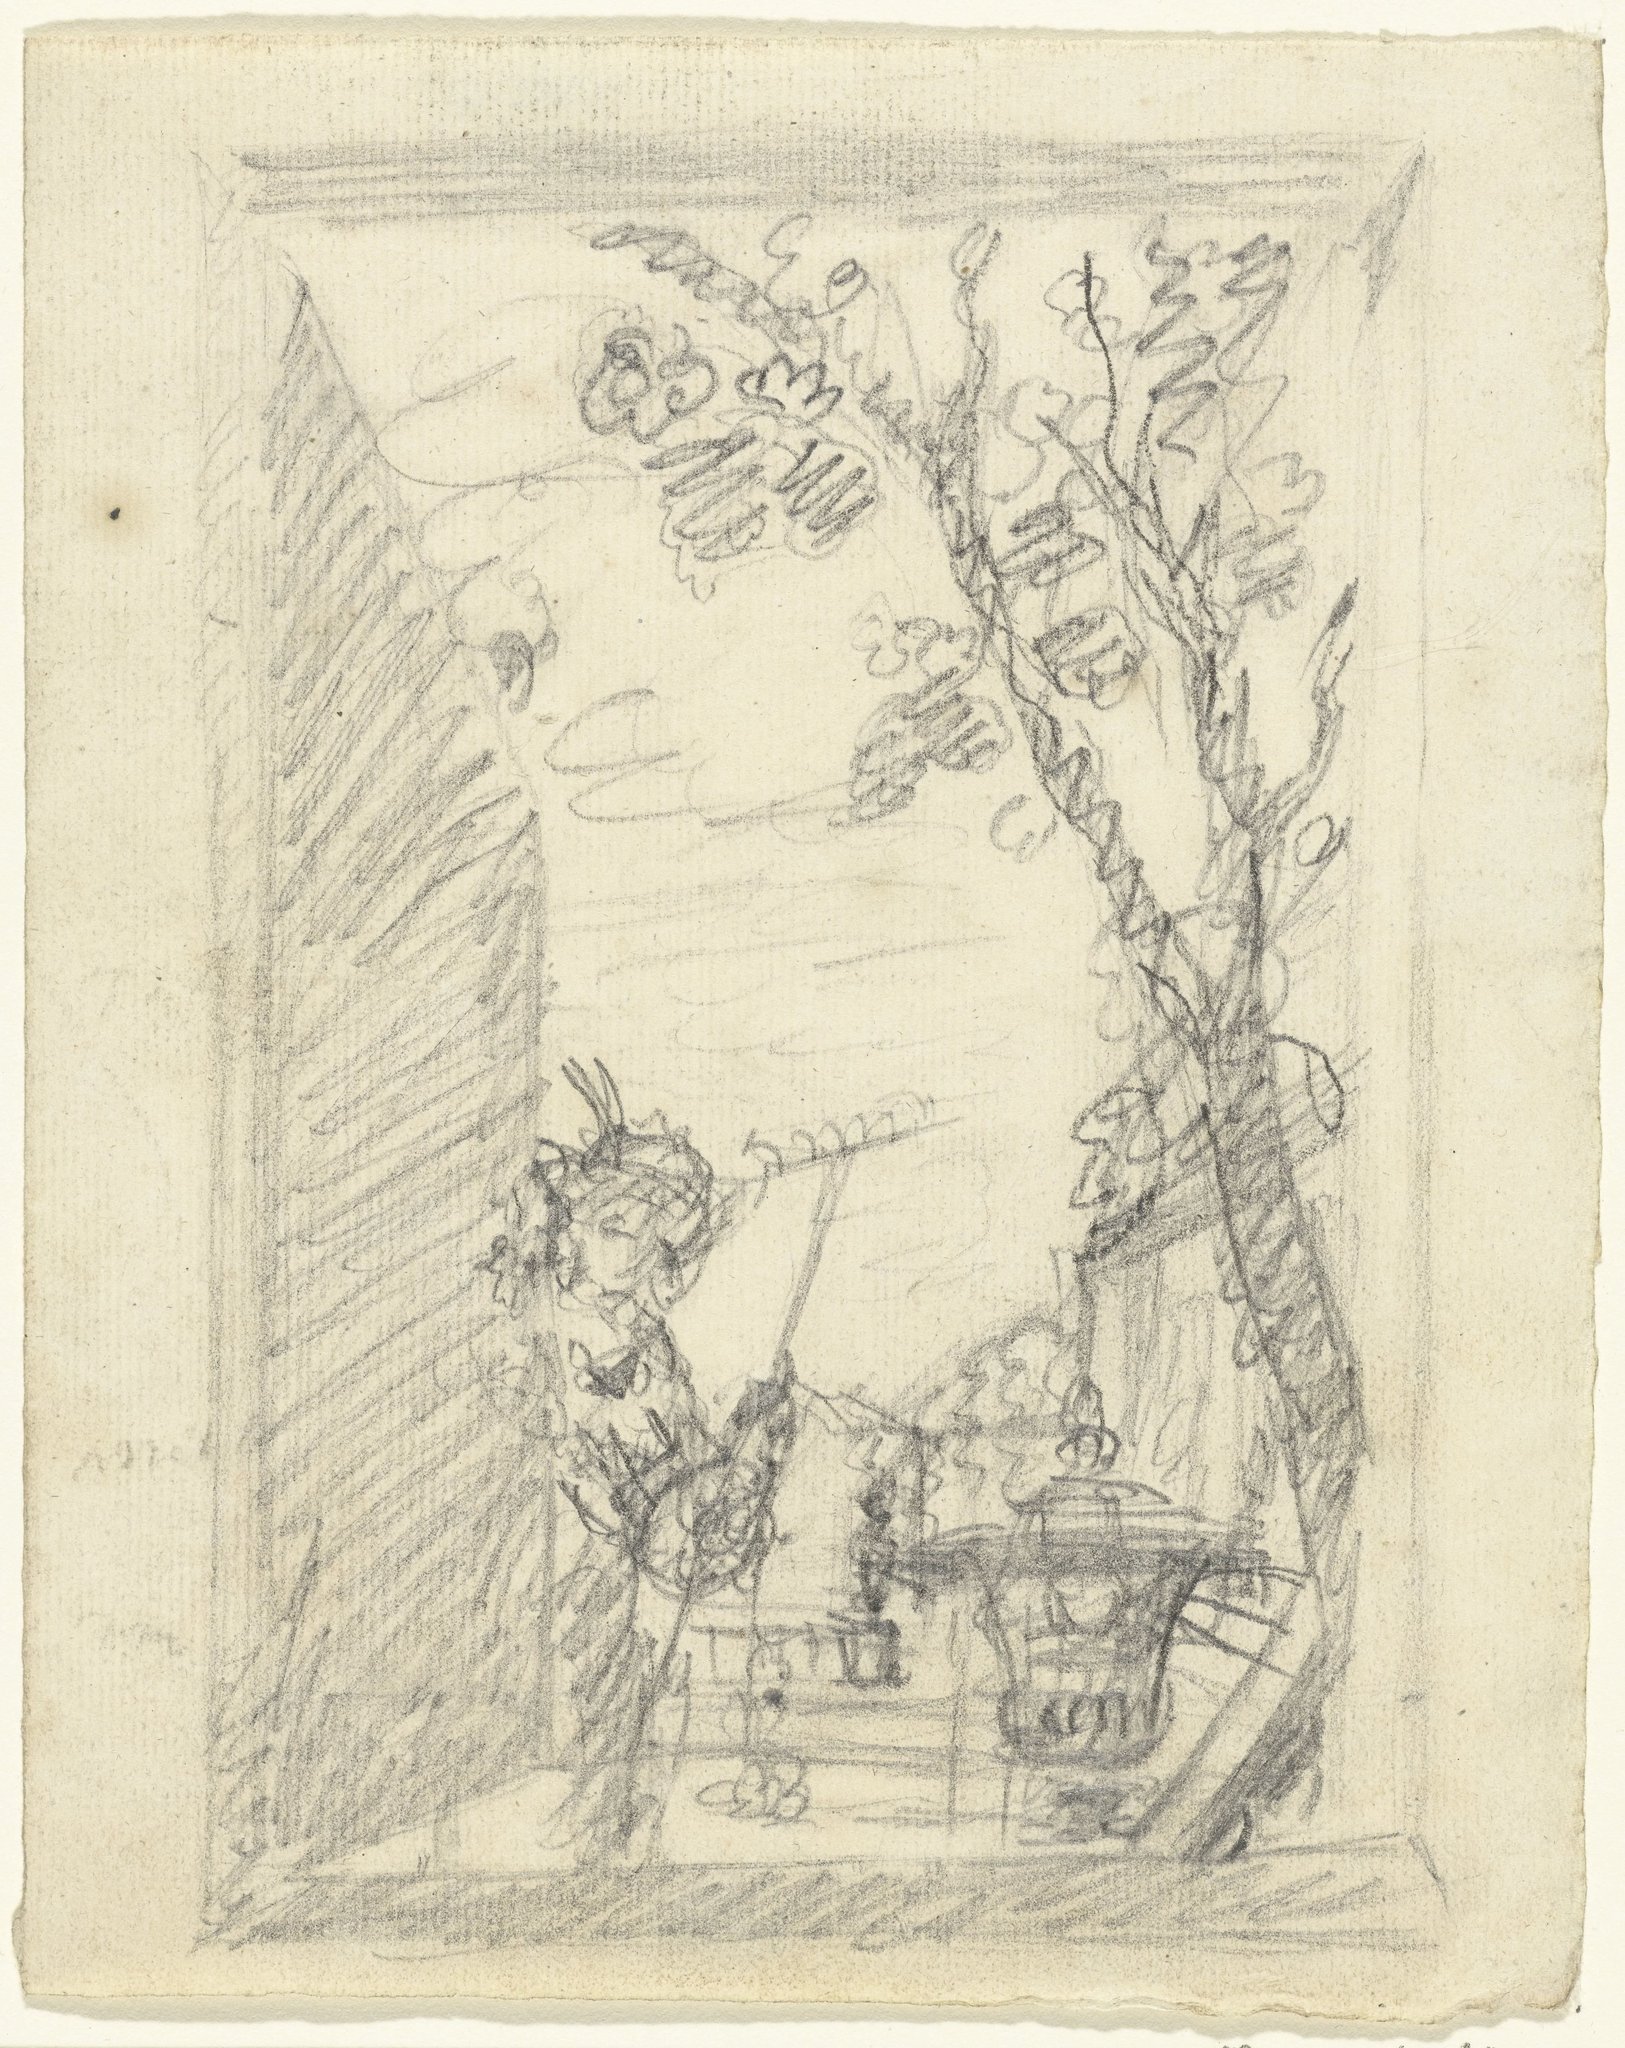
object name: drawing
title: Gezicht in een tuin met op de voorgrond een figuur met een hark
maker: dionys van nijmegen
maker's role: draughtsman, painter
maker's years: 1705-1798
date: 1715-1798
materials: paper, pencil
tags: garden